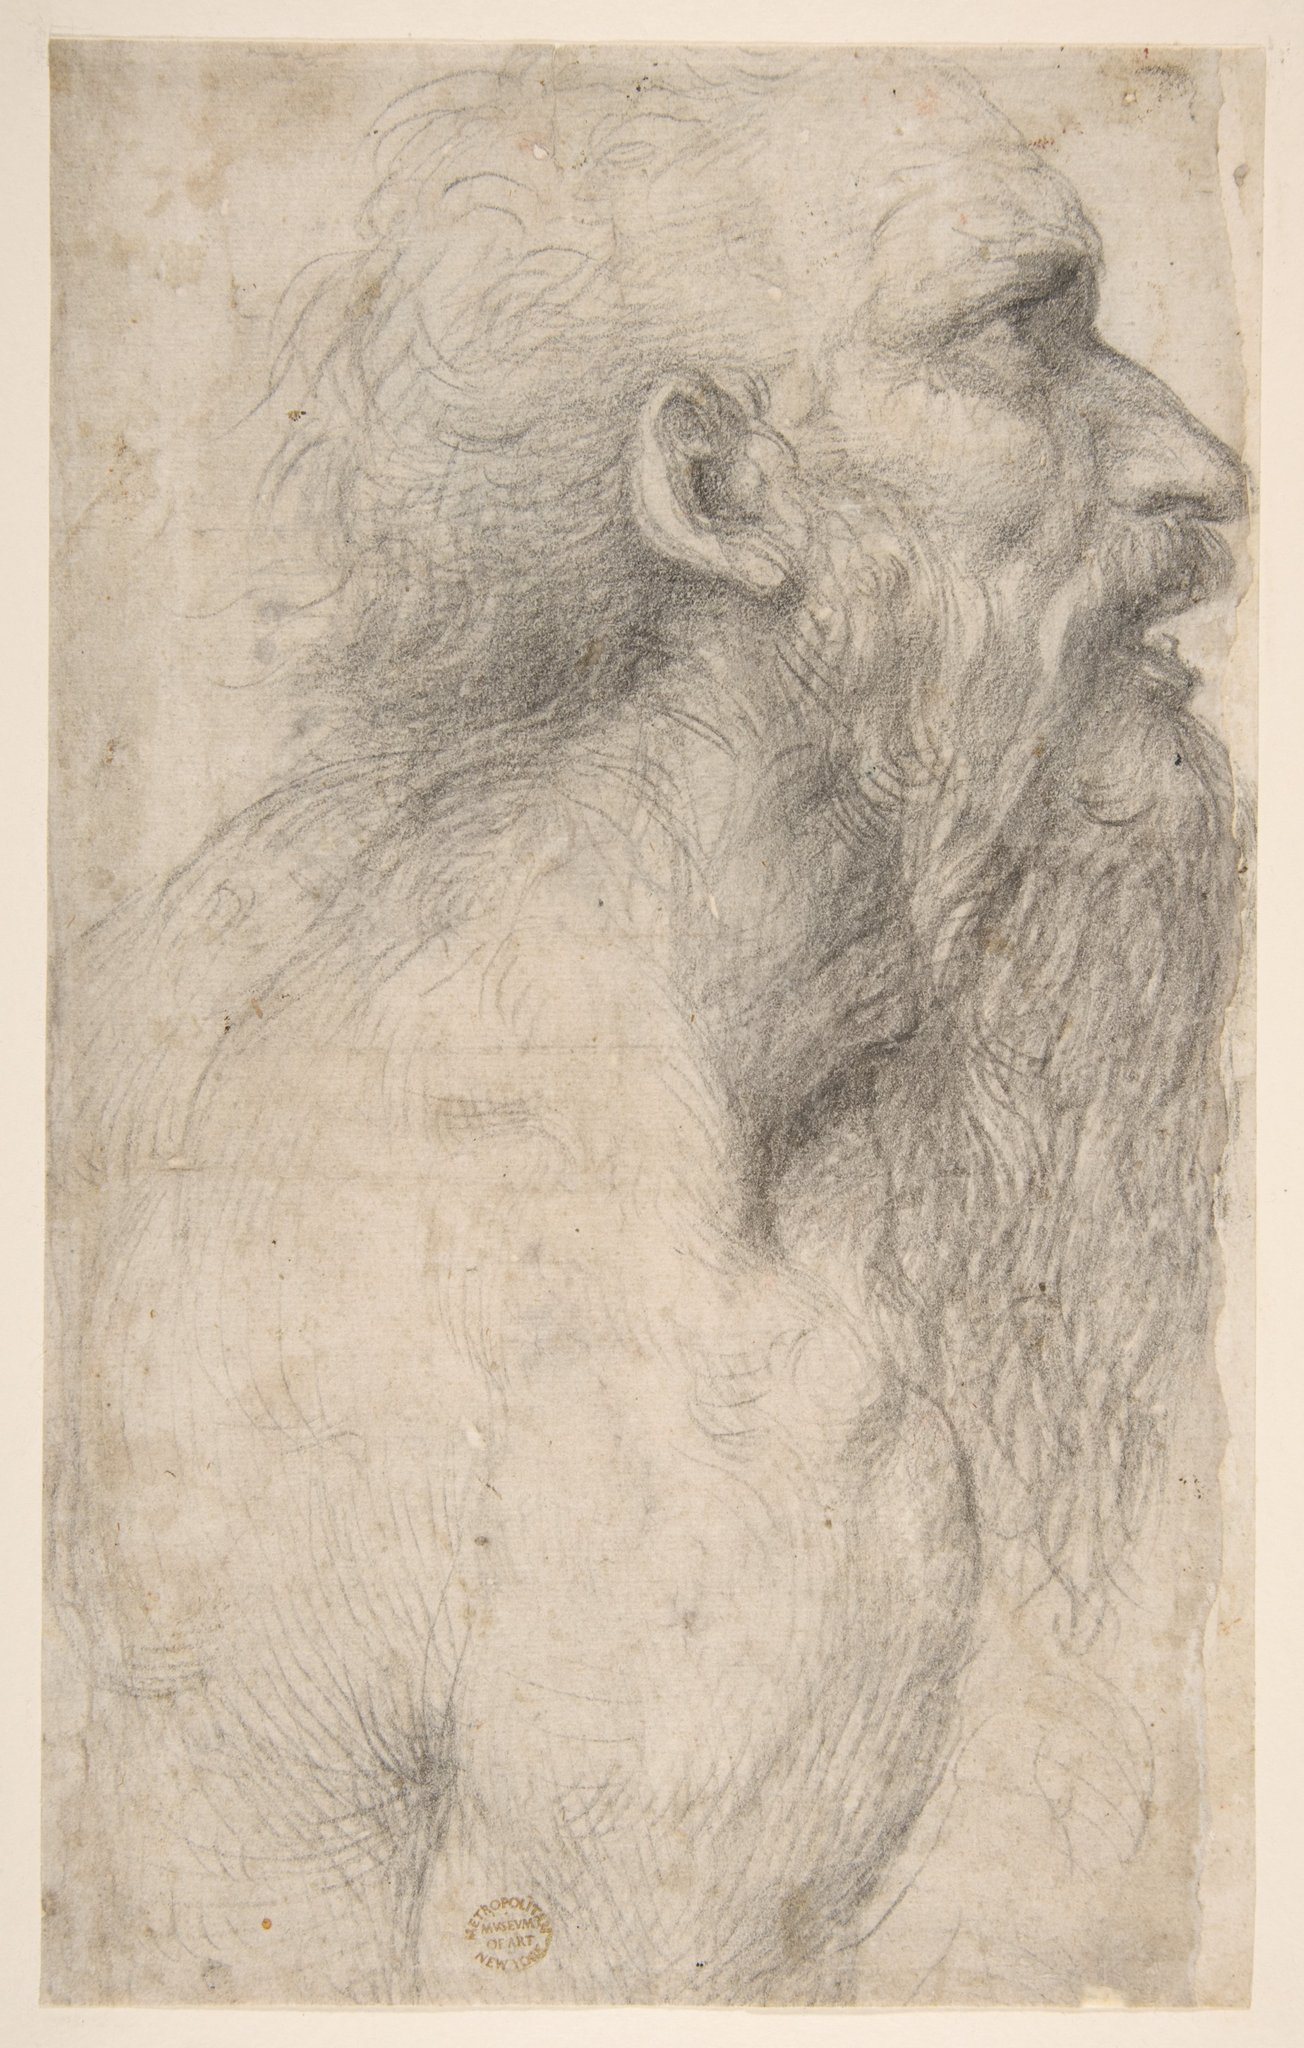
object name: drawing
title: Bust of a Man with Long Beard (recto)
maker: sodoma (giovanni antonio bazzi)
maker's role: artist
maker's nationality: italian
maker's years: 1477-1549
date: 1477-1549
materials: chalk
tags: men,profiles